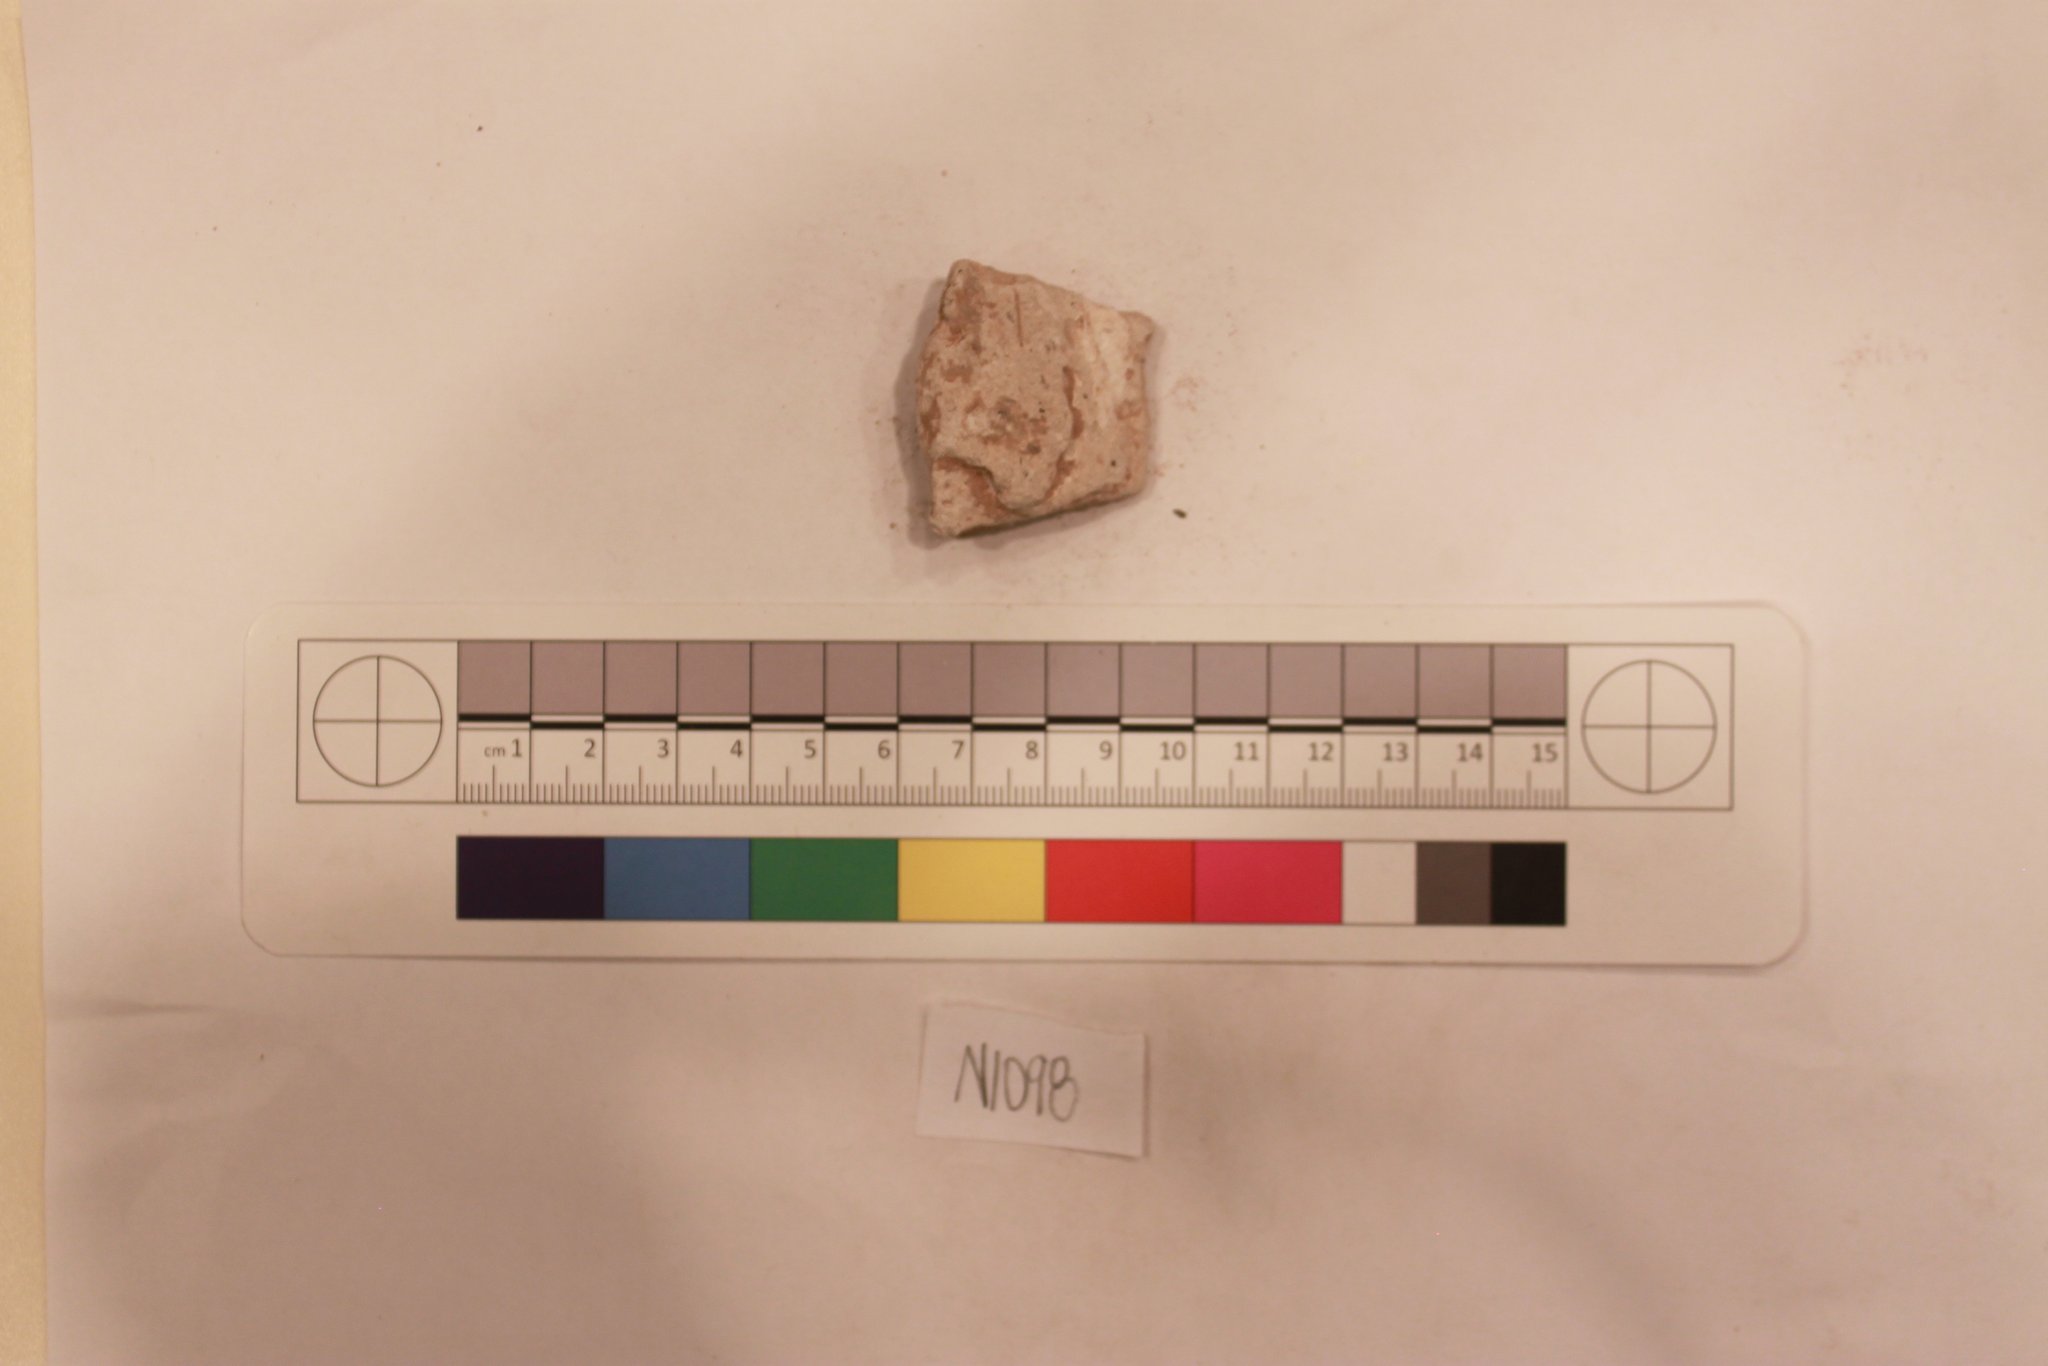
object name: fragment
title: Stucco Fragment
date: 701-1200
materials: plaster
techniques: carving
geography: iran